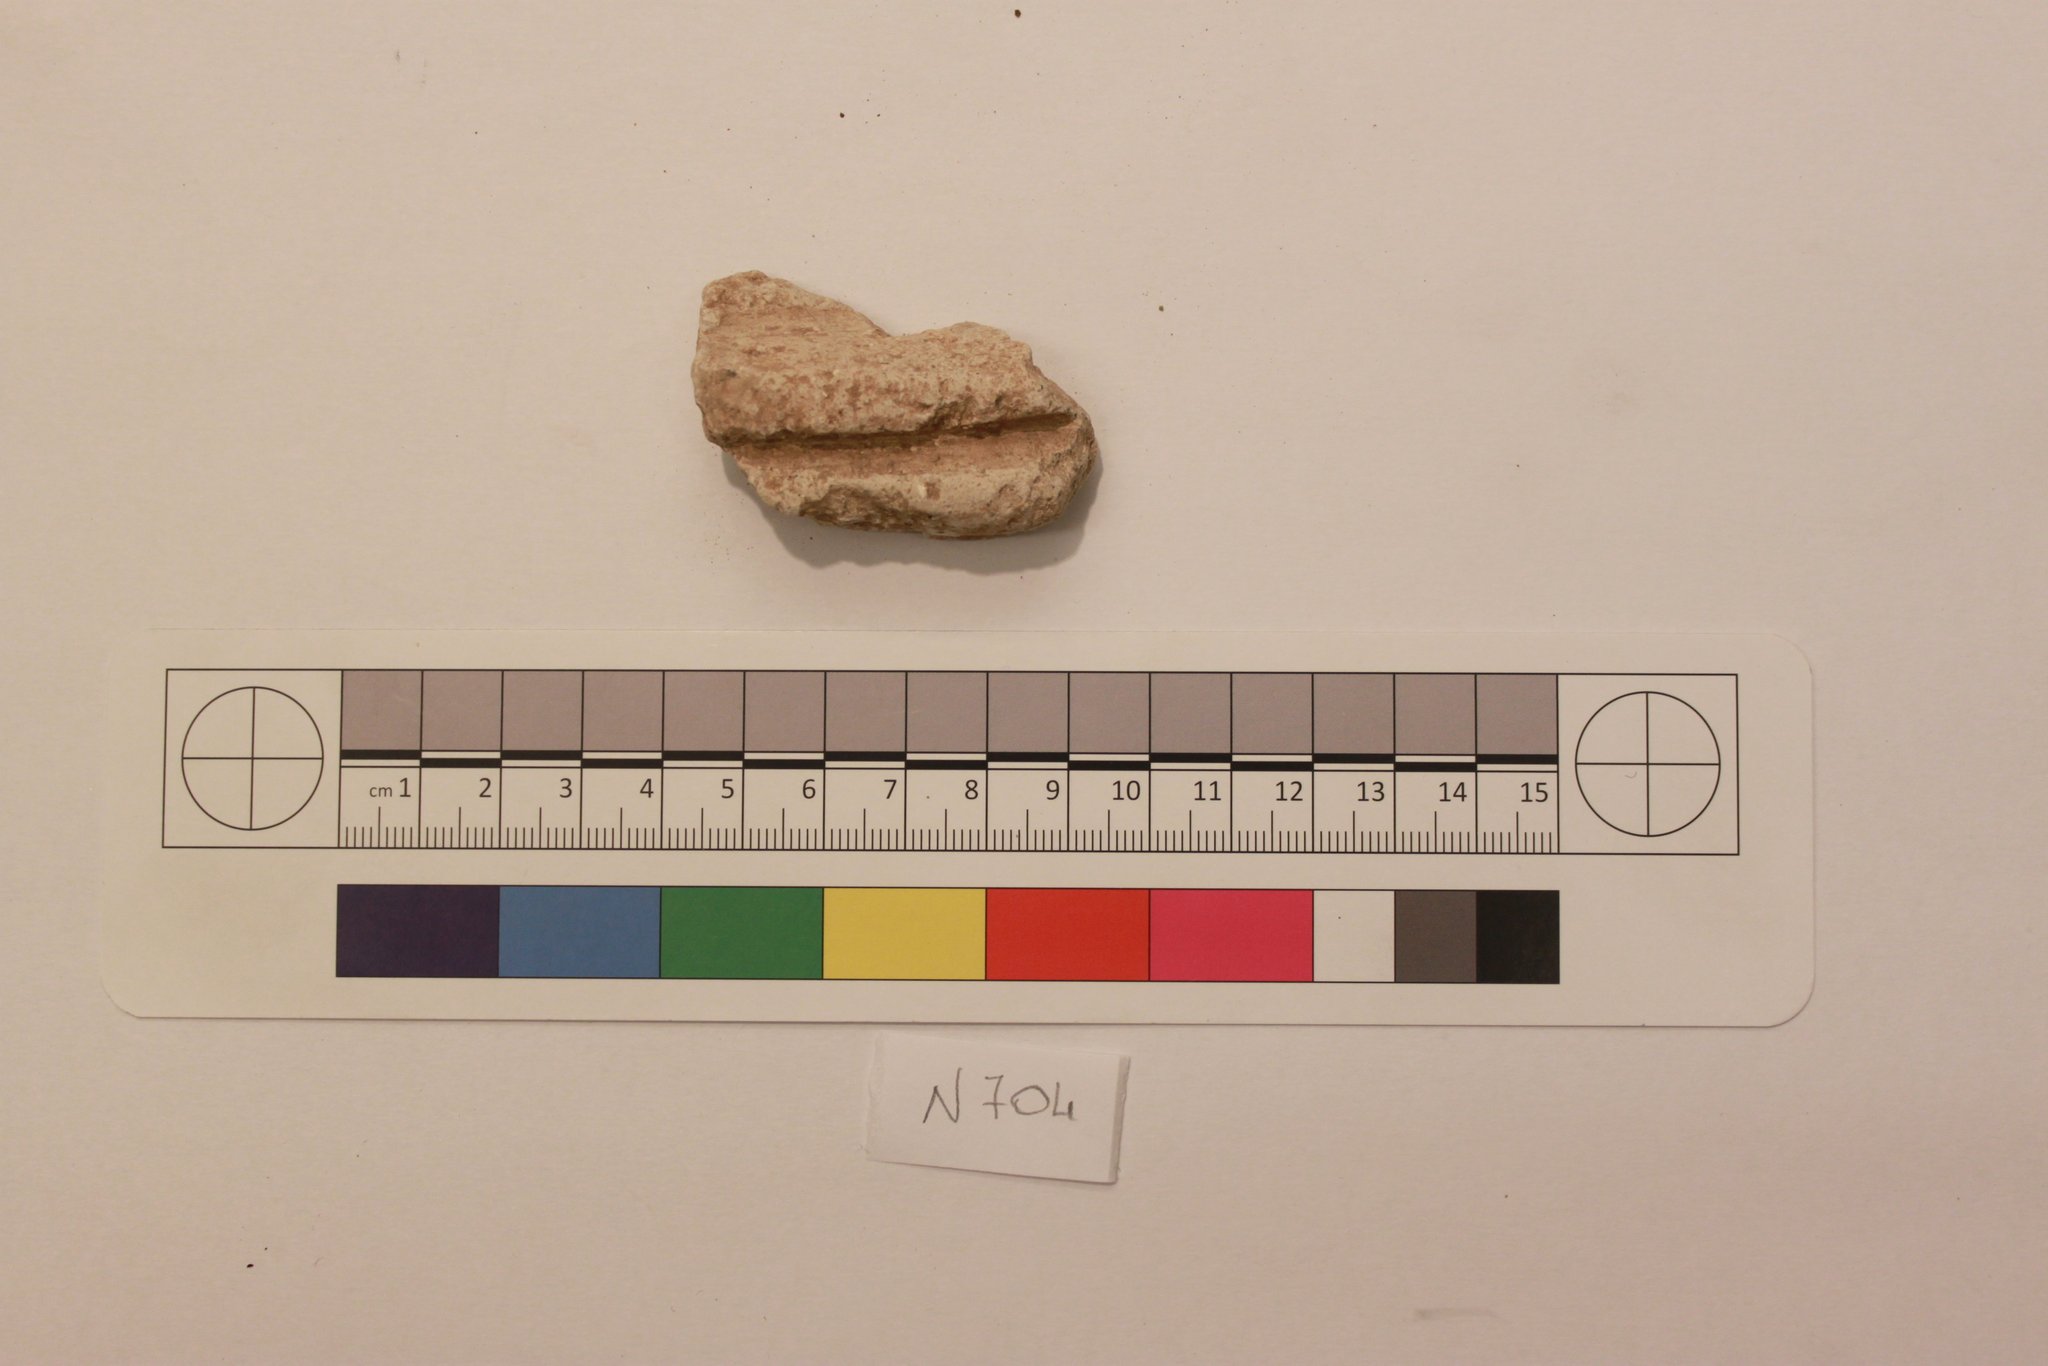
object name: fragment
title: Stucco Fragment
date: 701-1200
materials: plaster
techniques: carving, painting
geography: iran